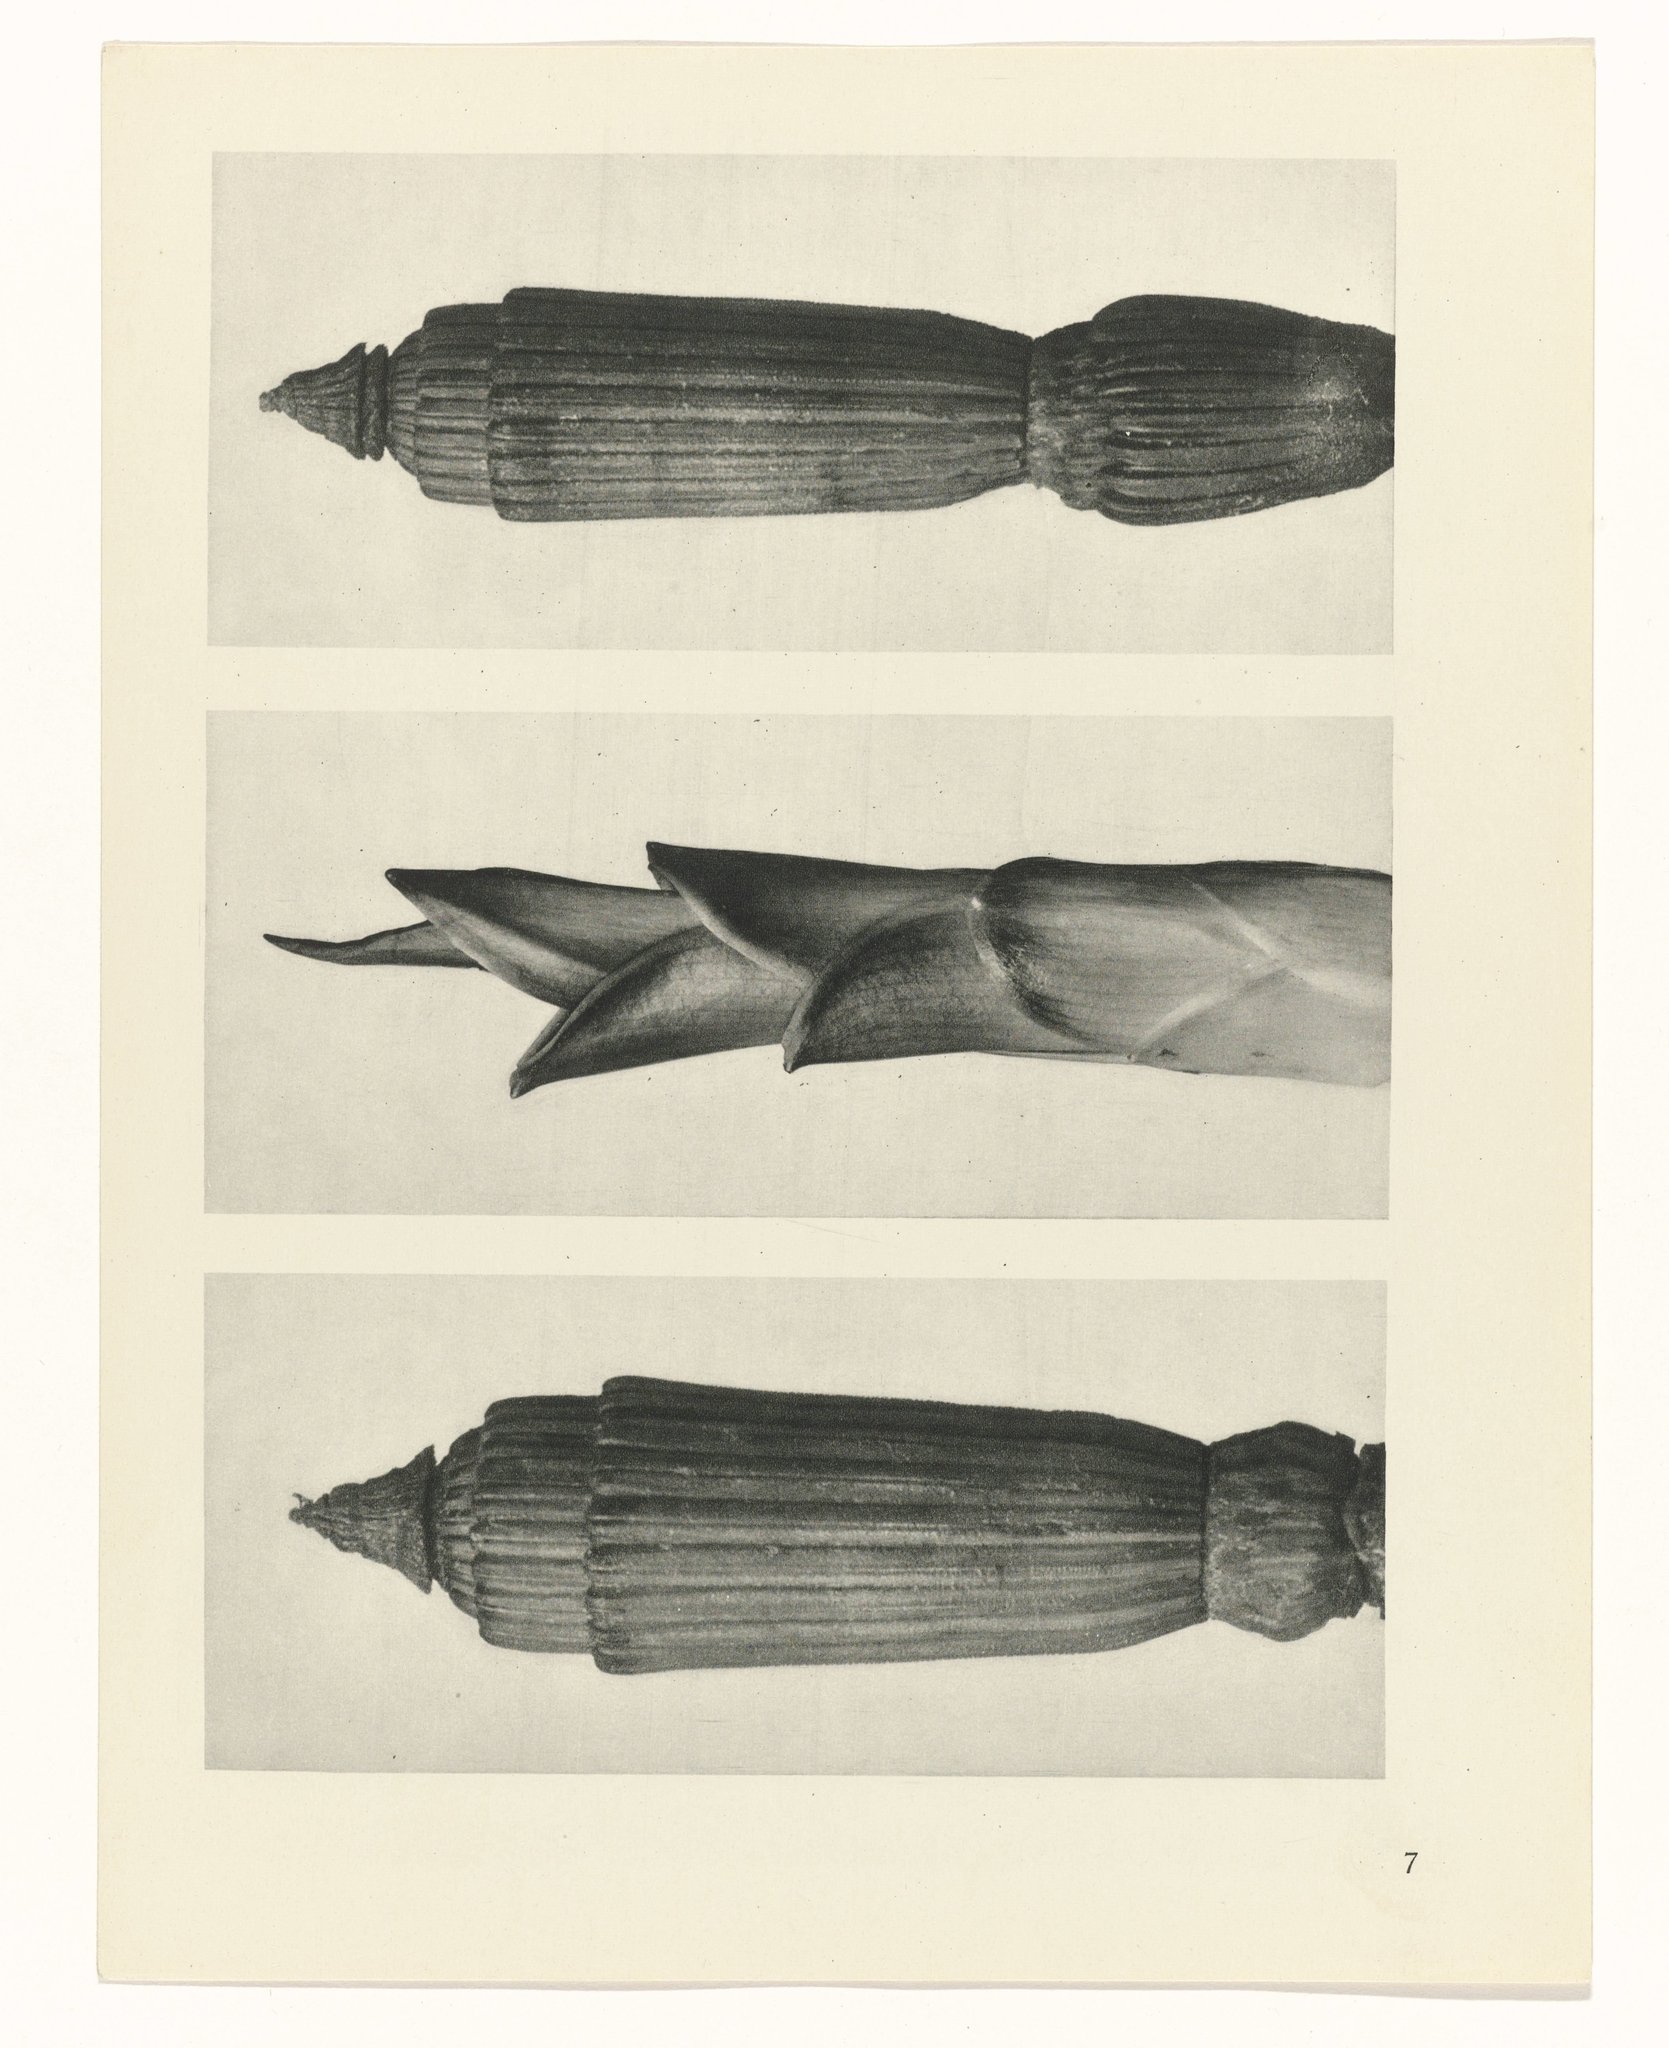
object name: photograph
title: Urformen der Kunst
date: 1928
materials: ink, paper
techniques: rotogravure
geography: berlin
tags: plants (in general)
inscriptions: number: ‘7’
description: facher Vergrößerung. Afkomstig uit losbladige uitgave.